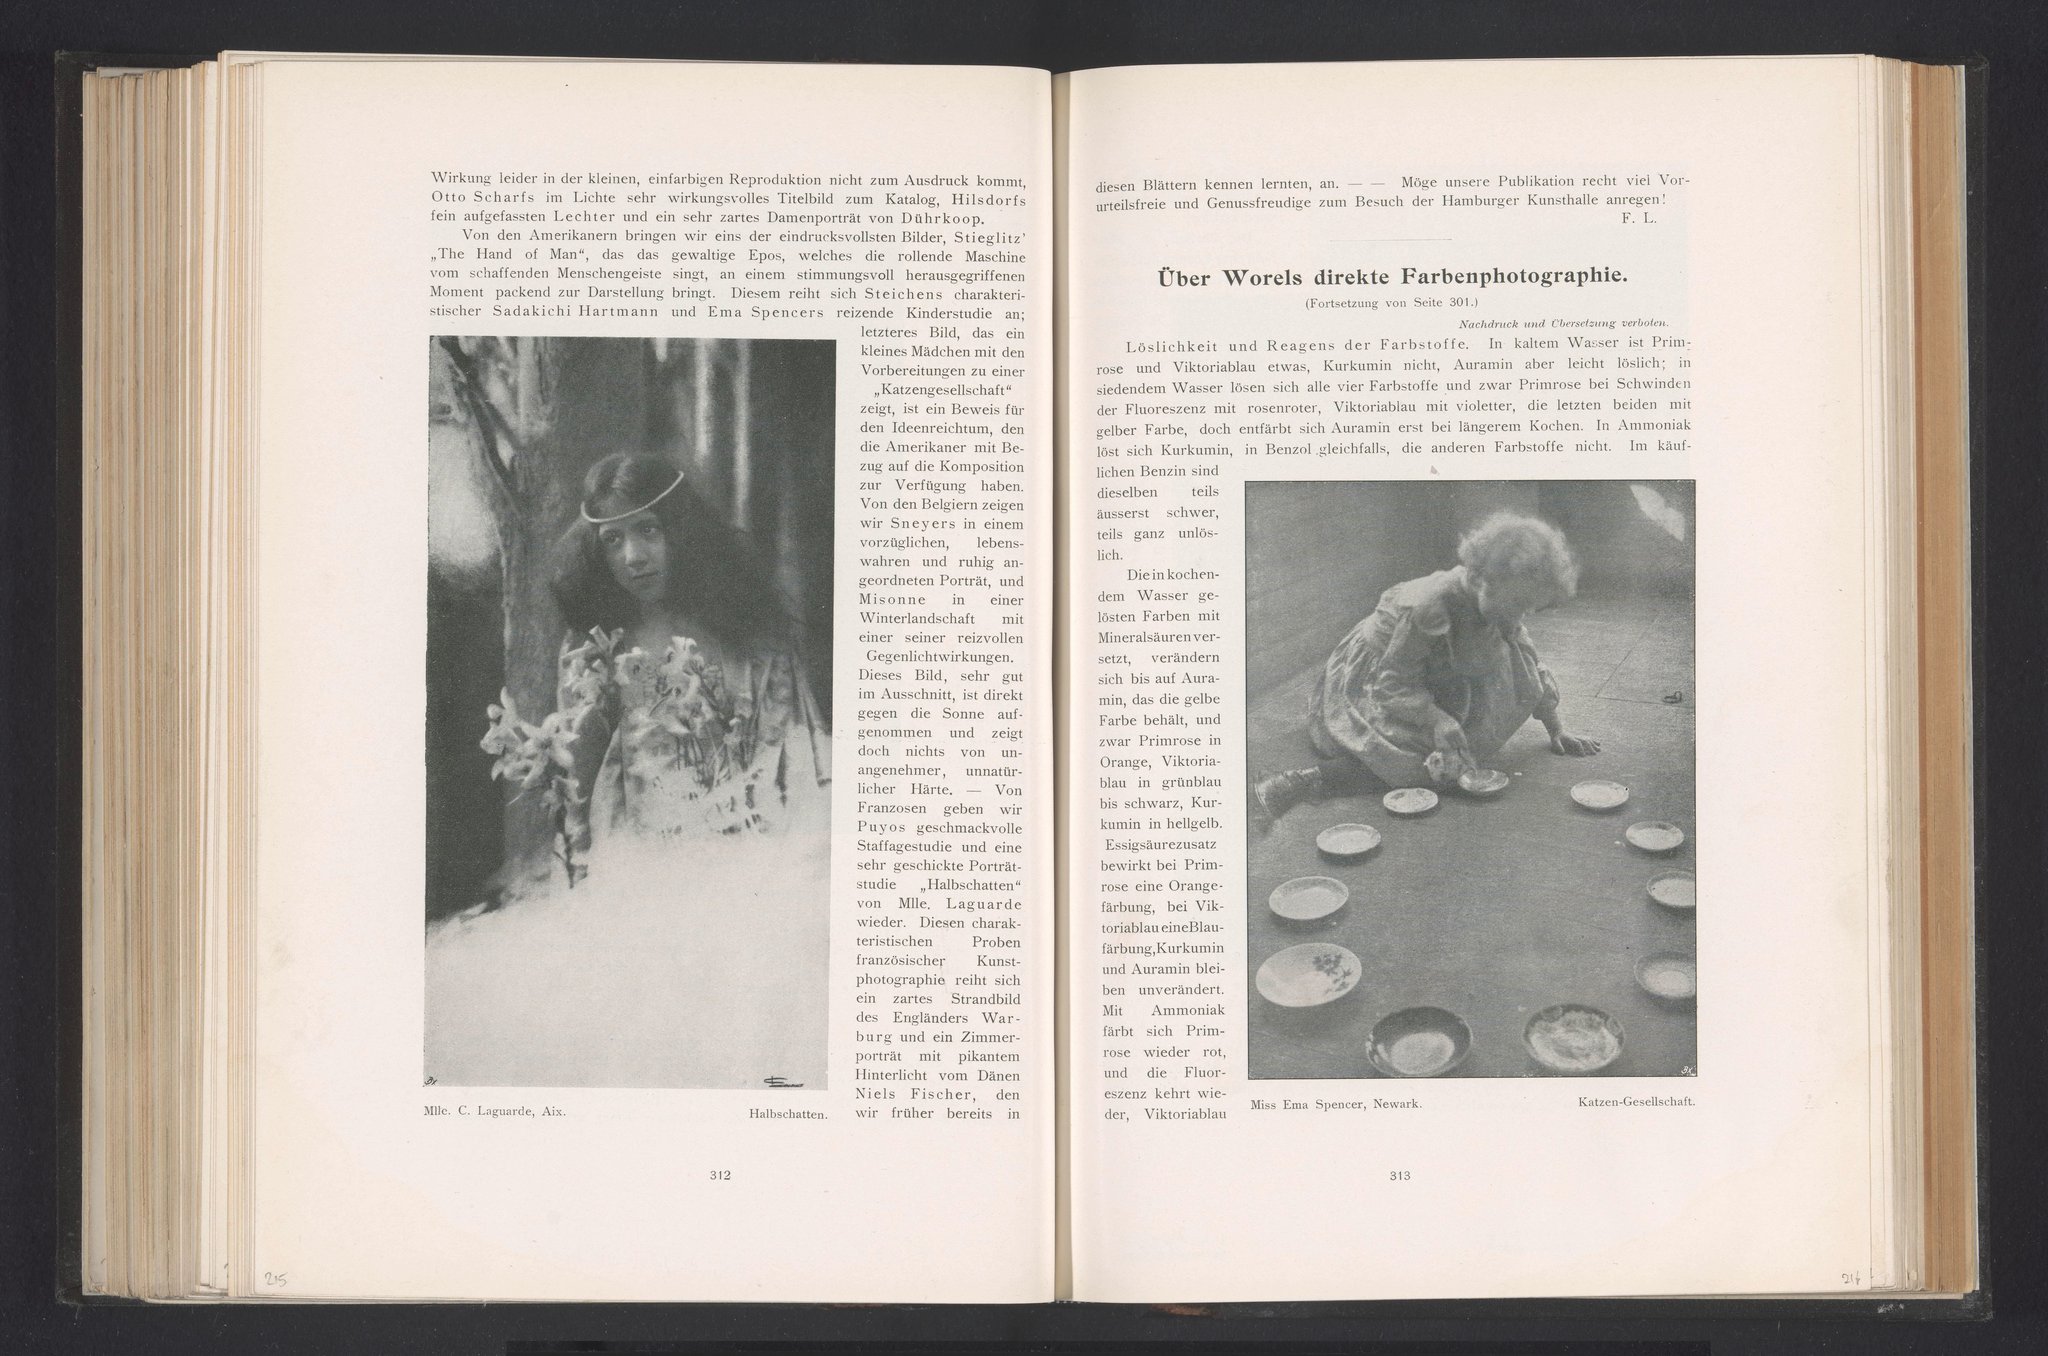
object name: page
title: Portret van een onbekend meisje met bloemen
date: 1898-1903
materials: paper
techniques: autotype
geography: aix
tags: historical persons - bb - woman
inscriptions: monogram: ‘BX’